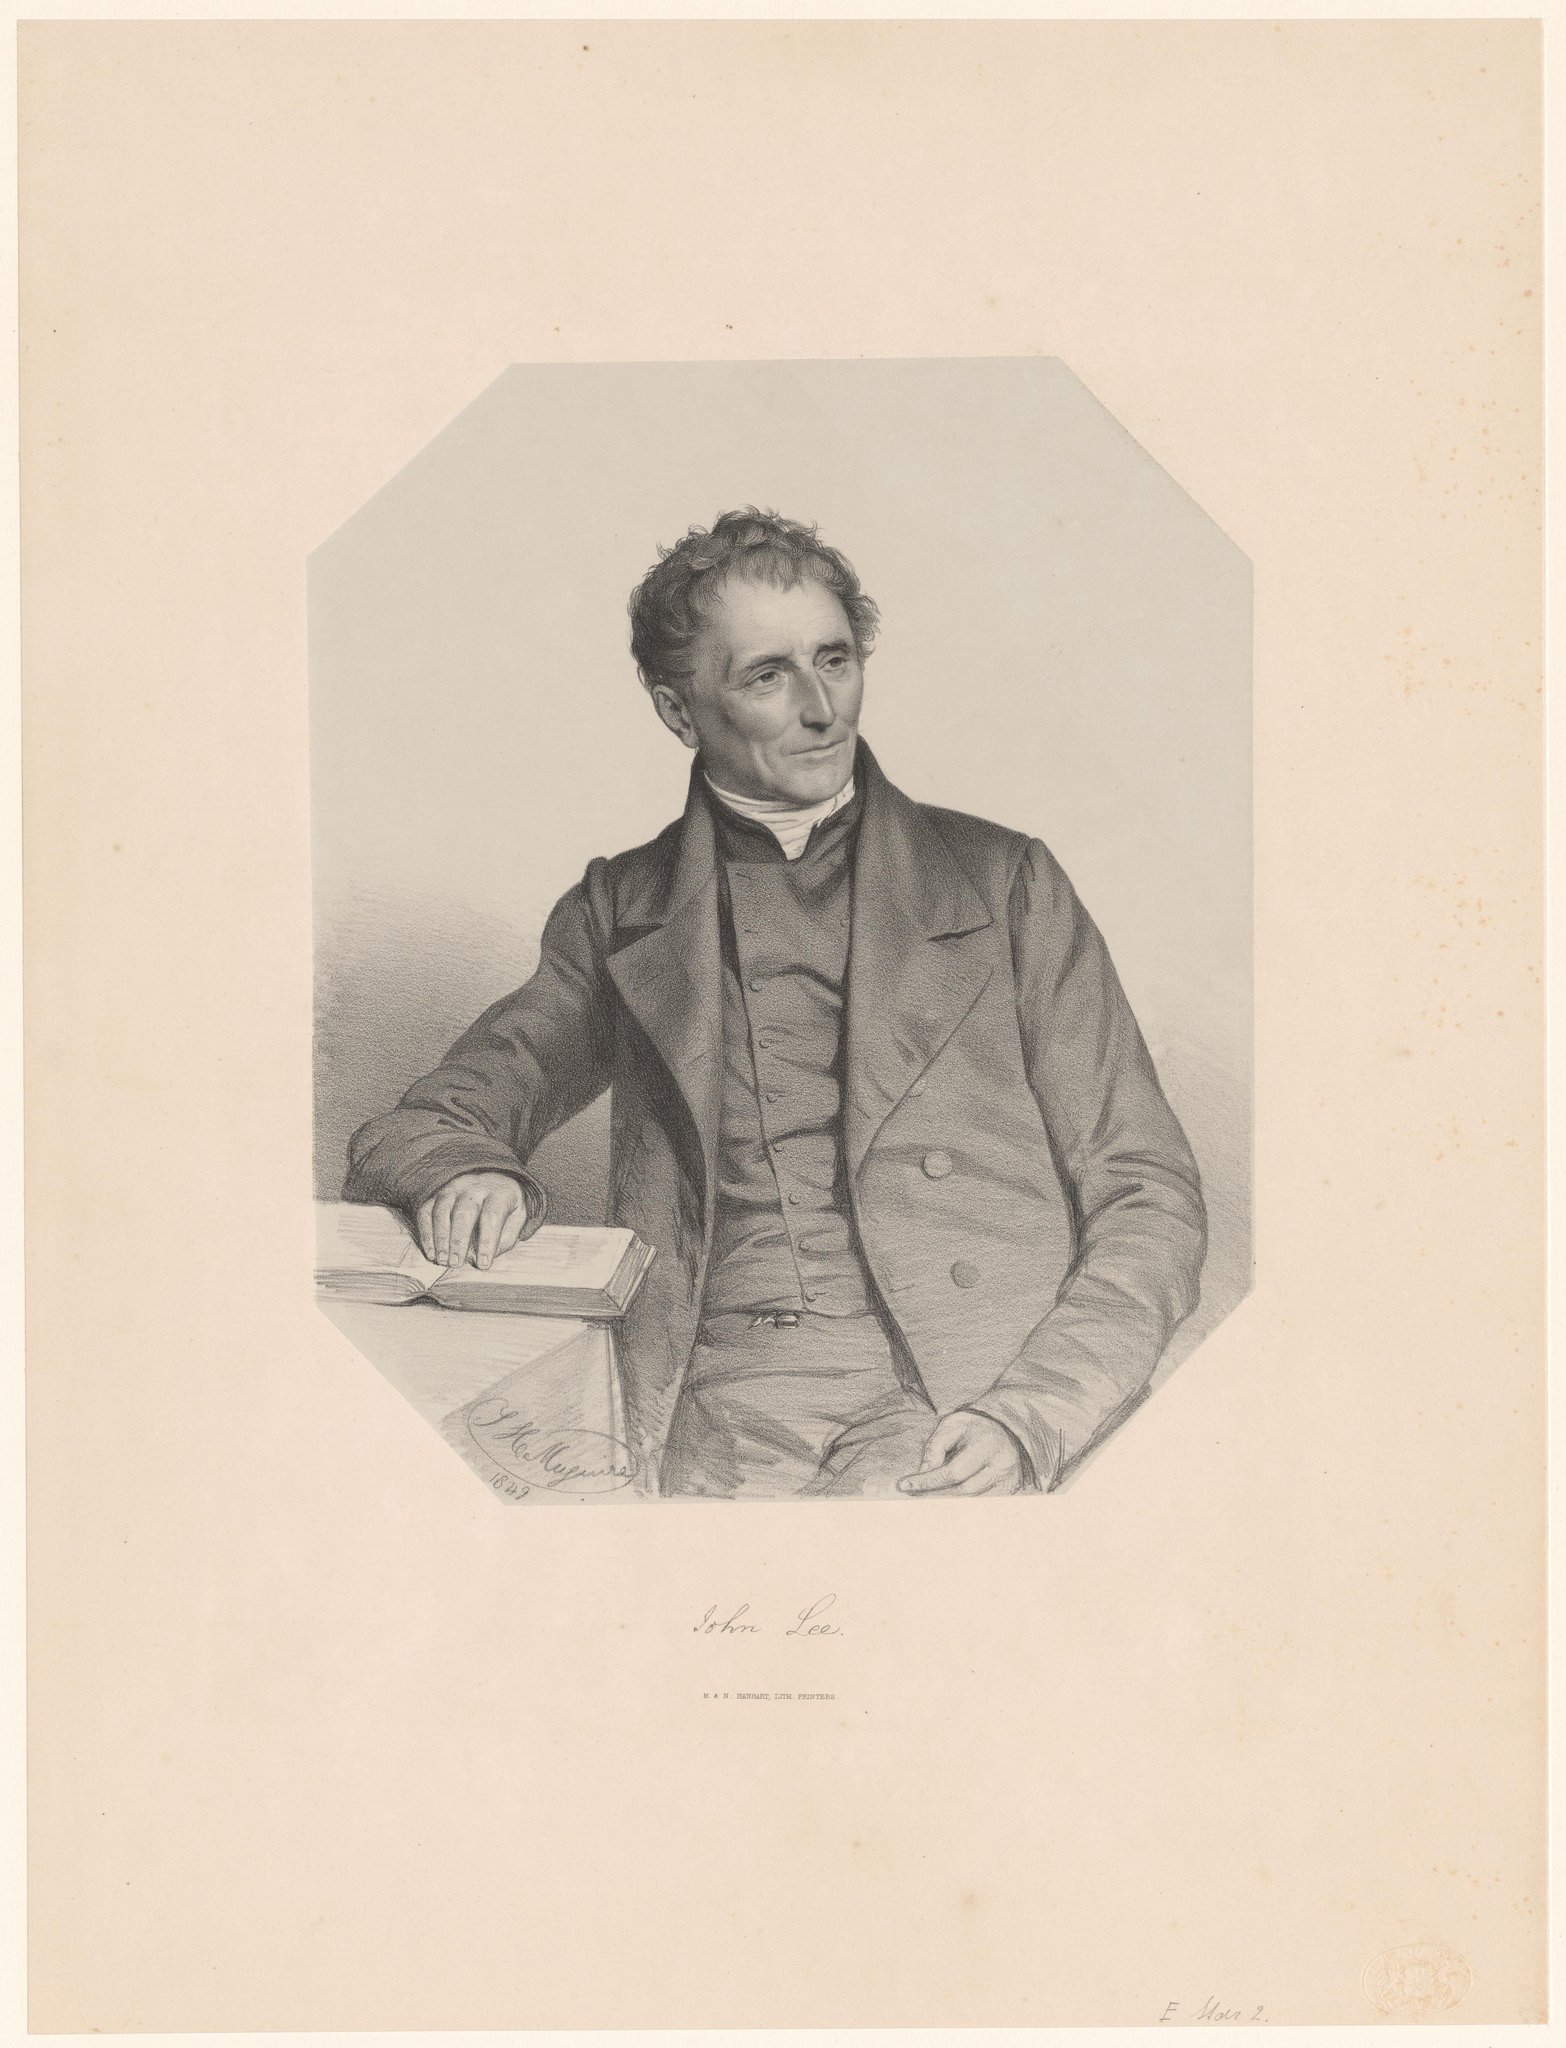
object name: print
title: Portretten uit het Ipswich Museum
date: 1852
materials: paper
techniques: lithograph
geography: london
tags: adult man, historical persons, book - mm - book open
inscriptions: check stamp: ‘Ipswich Museum’, collector's mark: Lugt 2228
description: Prent behoort tot de serie 'Ipswich Museum Portraits', ook bekend onder de titel 'Portraits of Honorary Members of the Ipswich Museum'. Deze serie is in 1852 door George Ransome uitgegeven en gedrukt door M&N Hanhart tussen 1848 en 1852. De serie bestaat uit ca. 60 portretten.